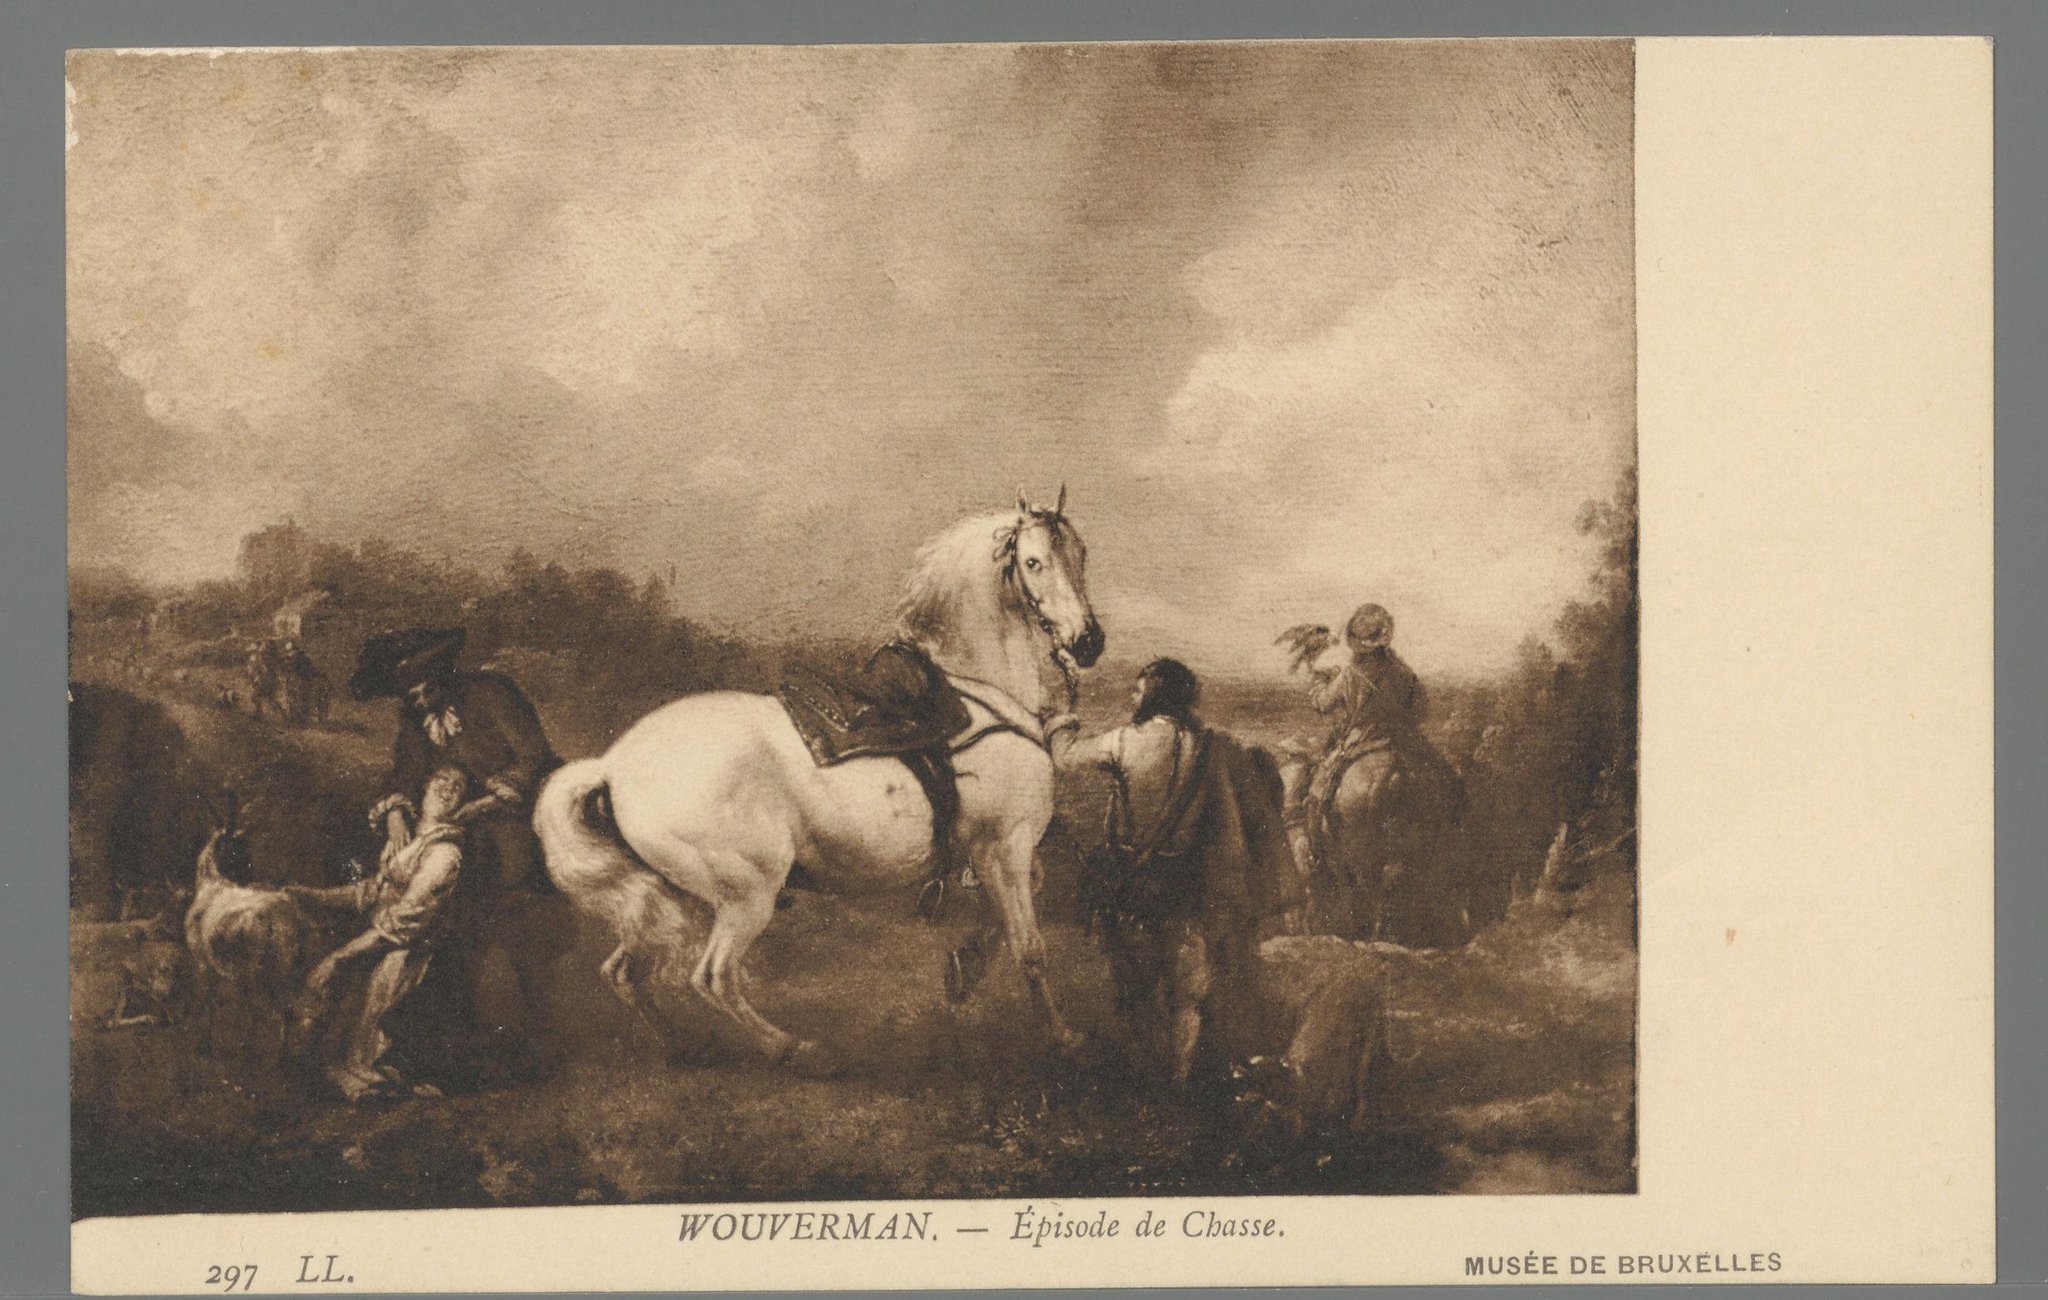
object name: reproduction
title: Wouverman - Épisode de Chasse. Musée de Bruxelles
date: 1903-1932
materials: cardboard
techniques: photograph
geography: paris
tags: permanent exhibition, museum, picture, painting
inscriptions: collector's mark: ‘AFE v S’